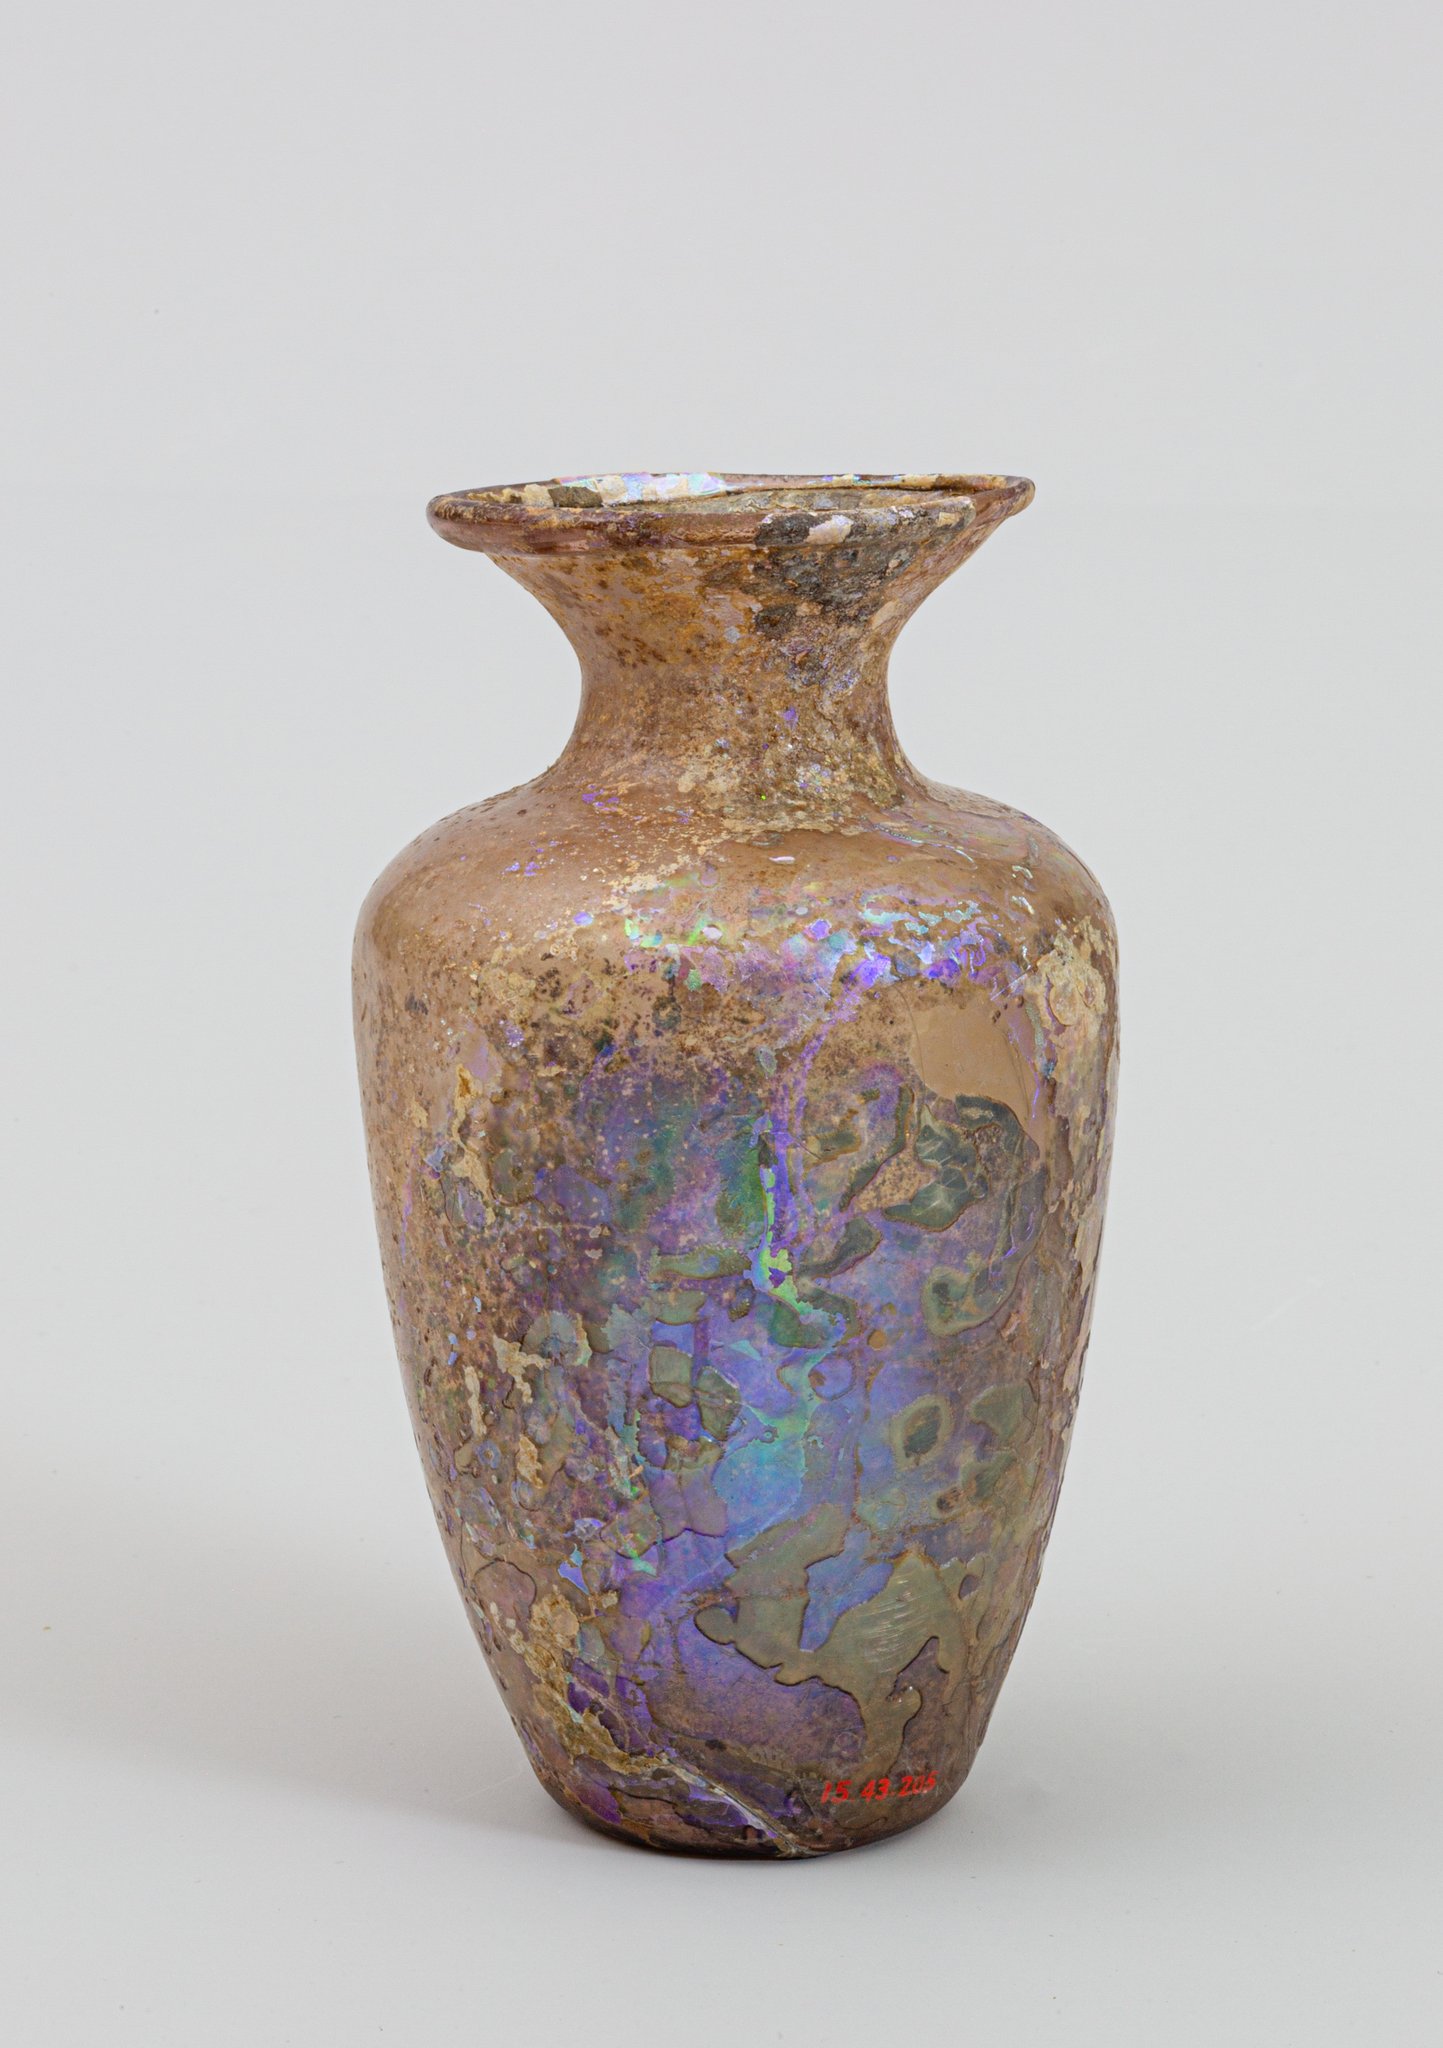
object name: jar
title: Glass jar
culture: roman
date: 201-400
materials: glass